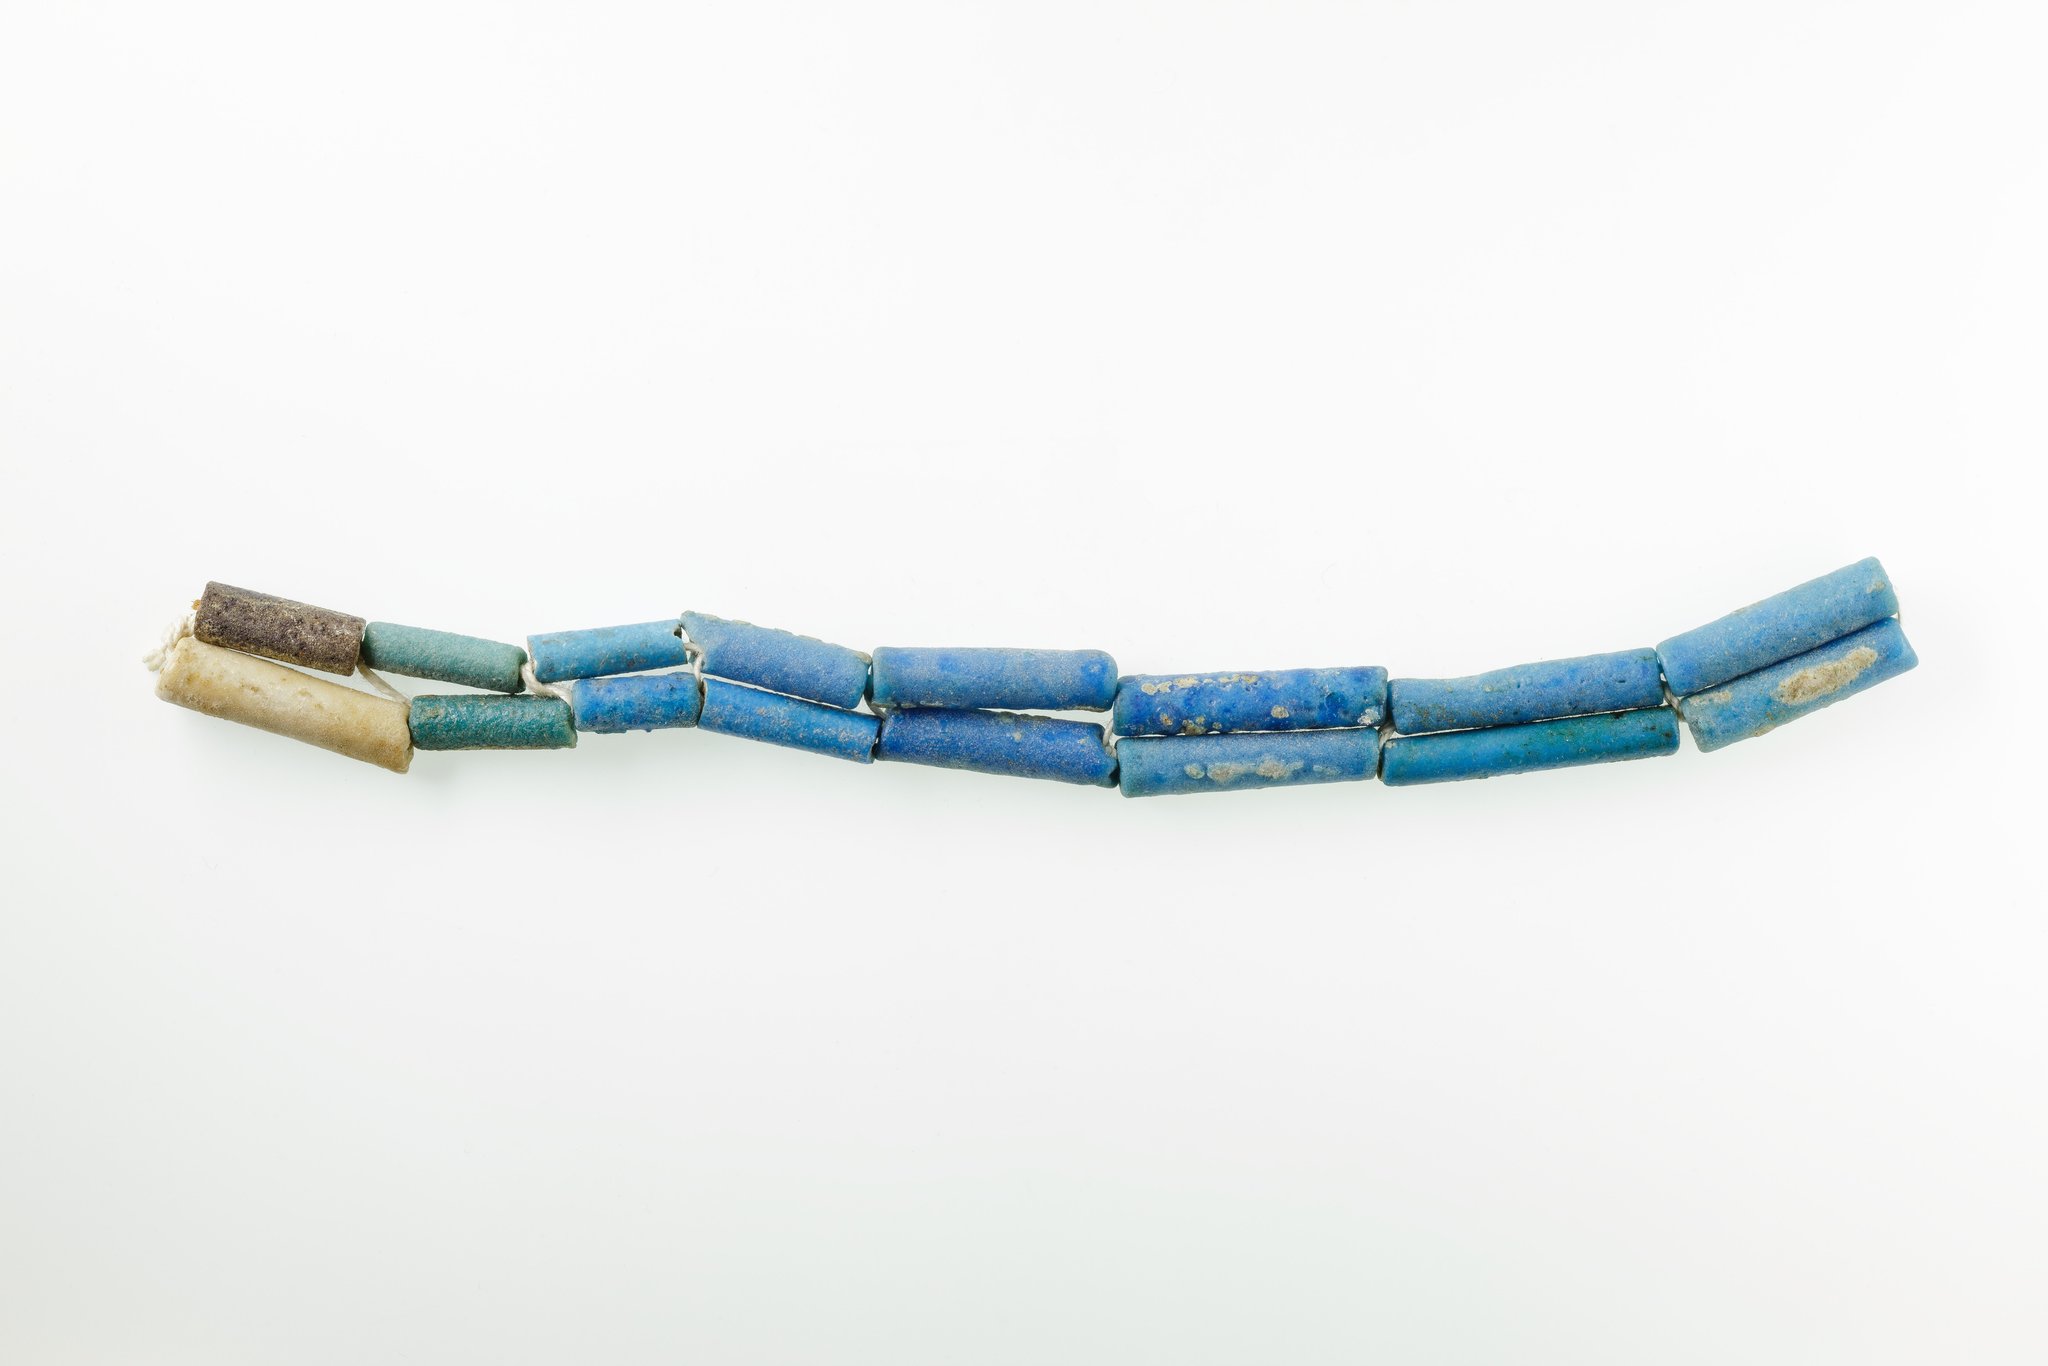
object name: bracelet or anklet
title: Bead bracelet or anklet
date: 2060-2010 BCE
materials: faience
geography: egypt